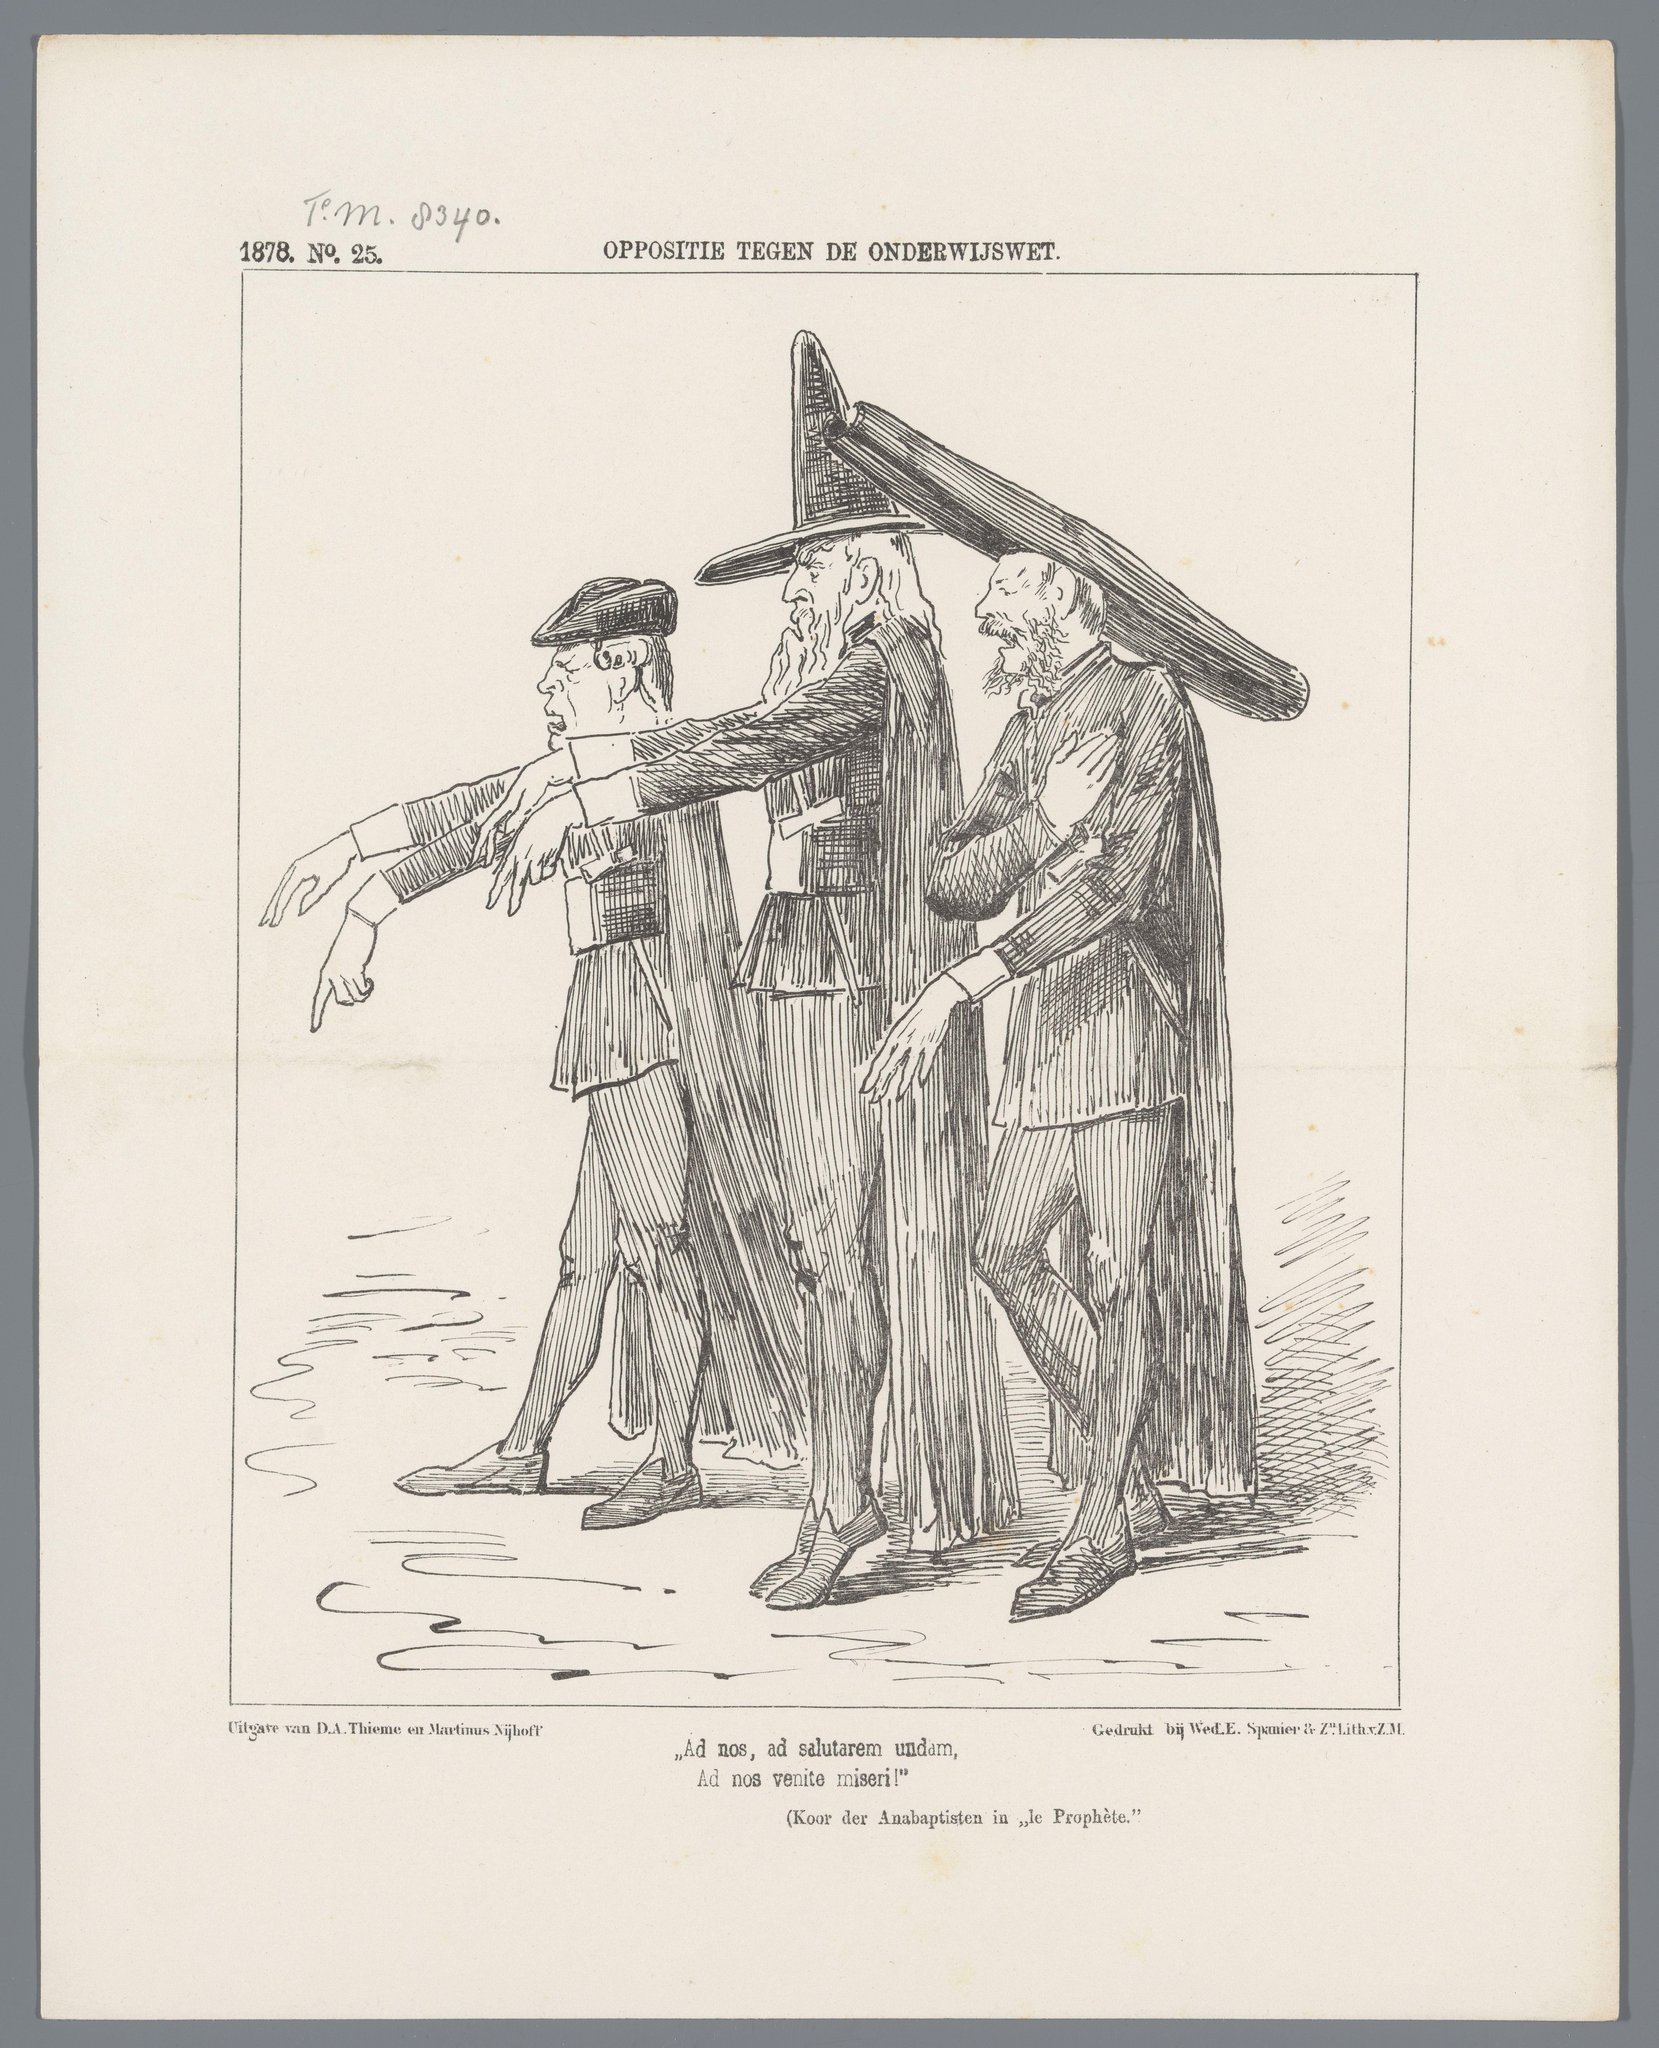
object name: cartoon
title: Spotprent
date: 1878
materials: paper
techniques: lithograph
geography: arnhem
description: Spotprent. Plaat verschenen bij het weekblad De Nederlandsche Spectator, nr. 25, 1878.